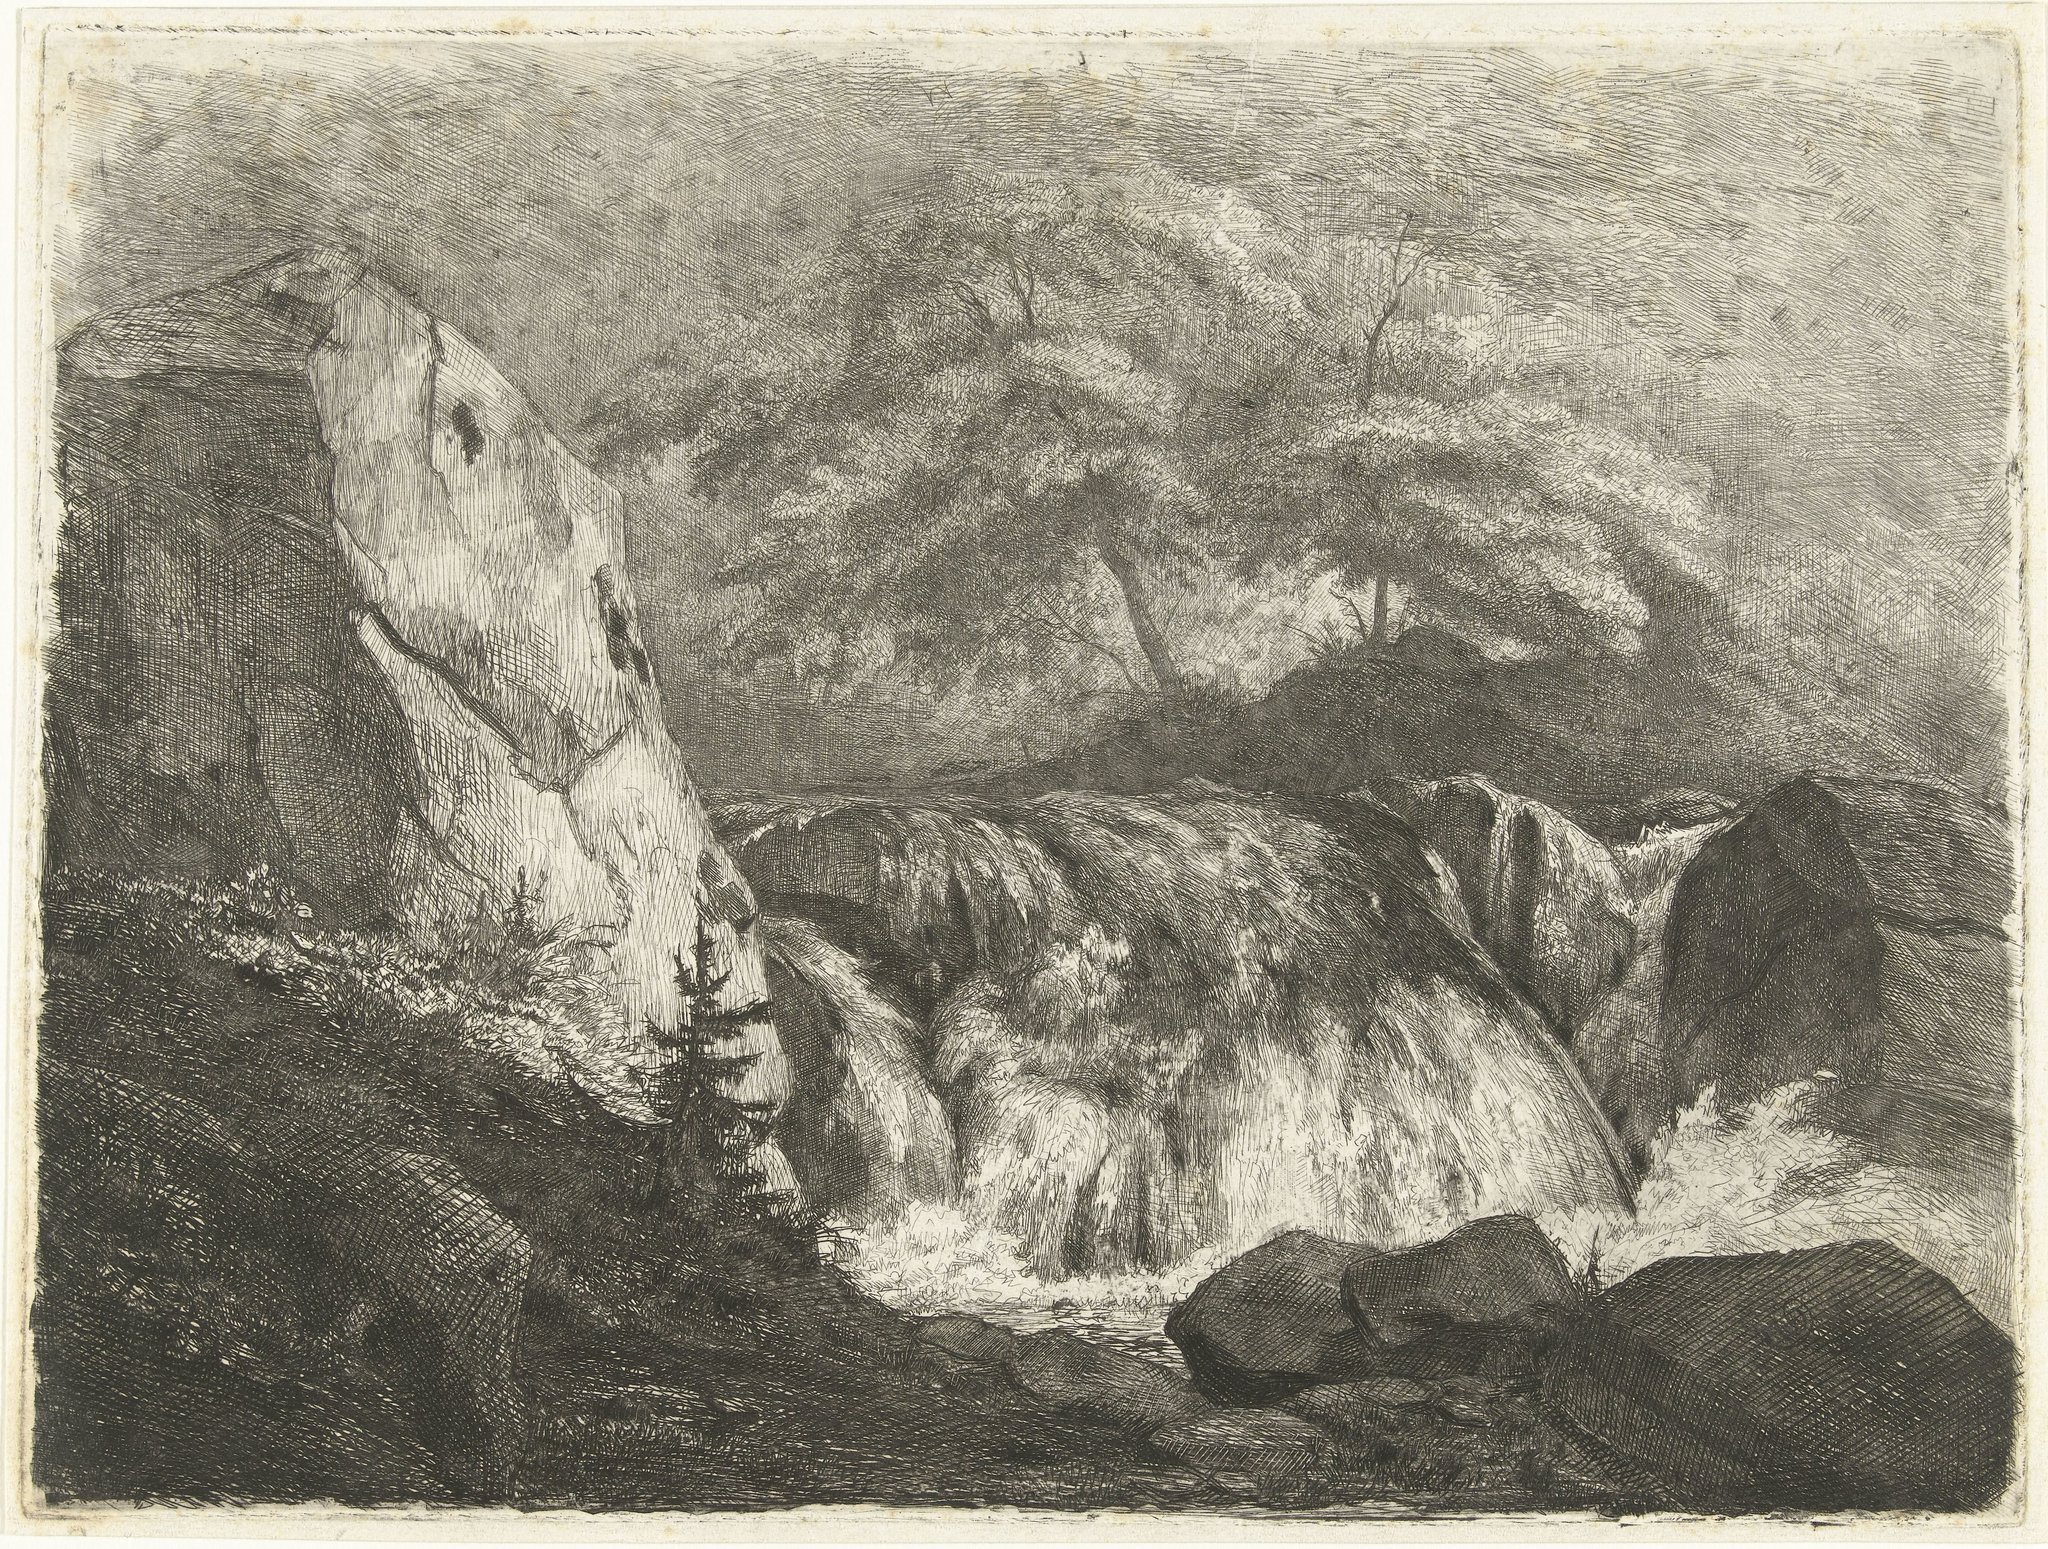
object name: print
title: Rotslandschap met waterval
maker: pierre louis dubourcq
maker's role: draughtsman, painter, print maker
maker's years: 1815-1873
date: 1830-1858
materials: paper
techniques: drypoint, etching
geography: netherlands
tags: waterfall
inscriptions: collector's mark: Lugt 2228